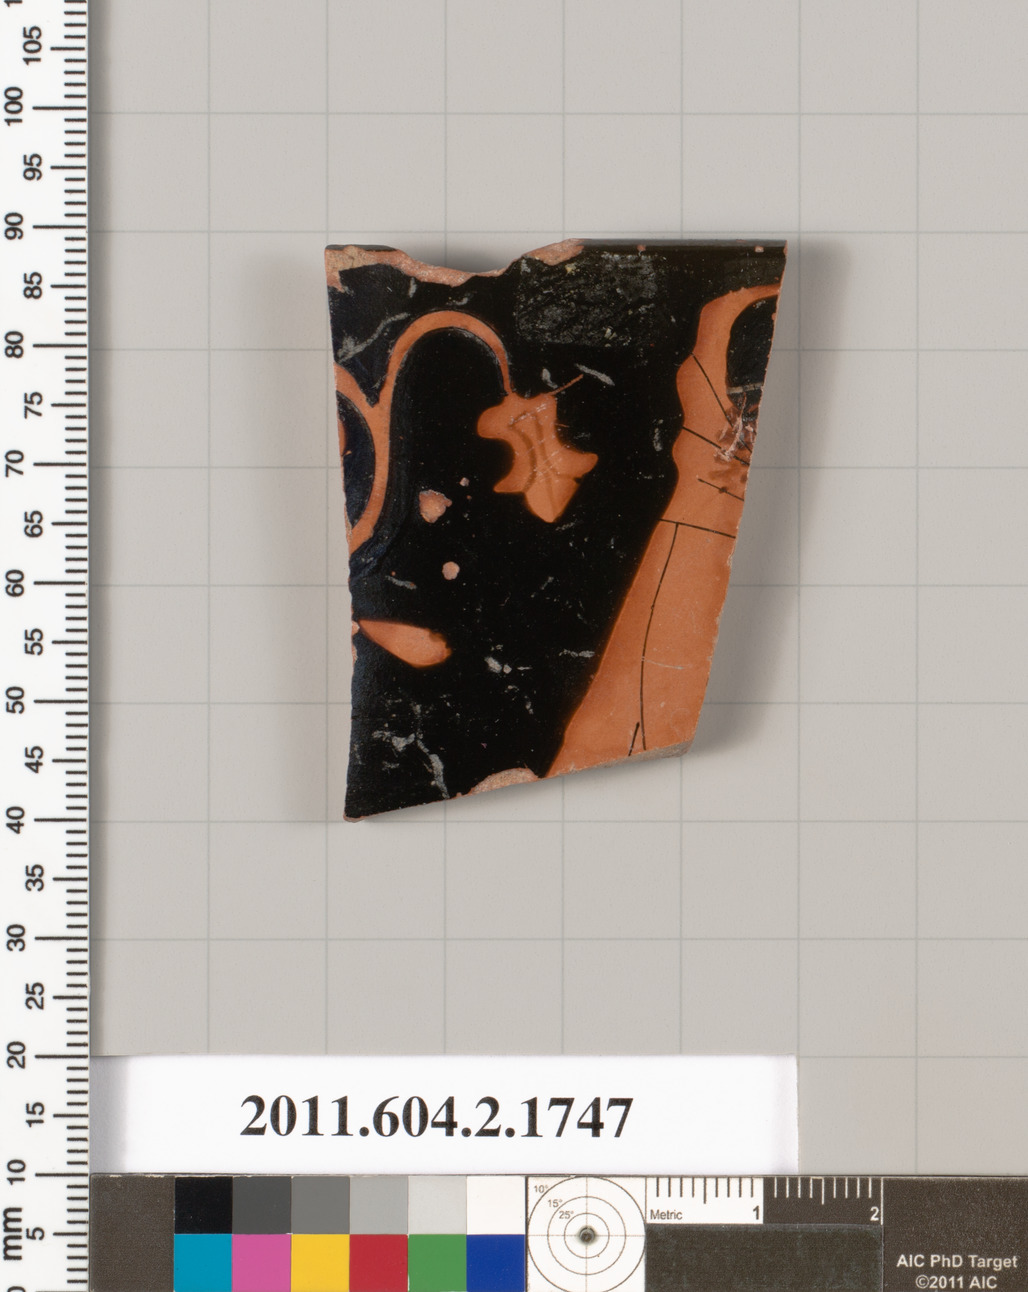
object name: skyphos fragment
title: Terracotta rim fragment of a skyphos (deep drinking cup)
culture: greek, attic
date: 460-440 BCE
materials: terracotta